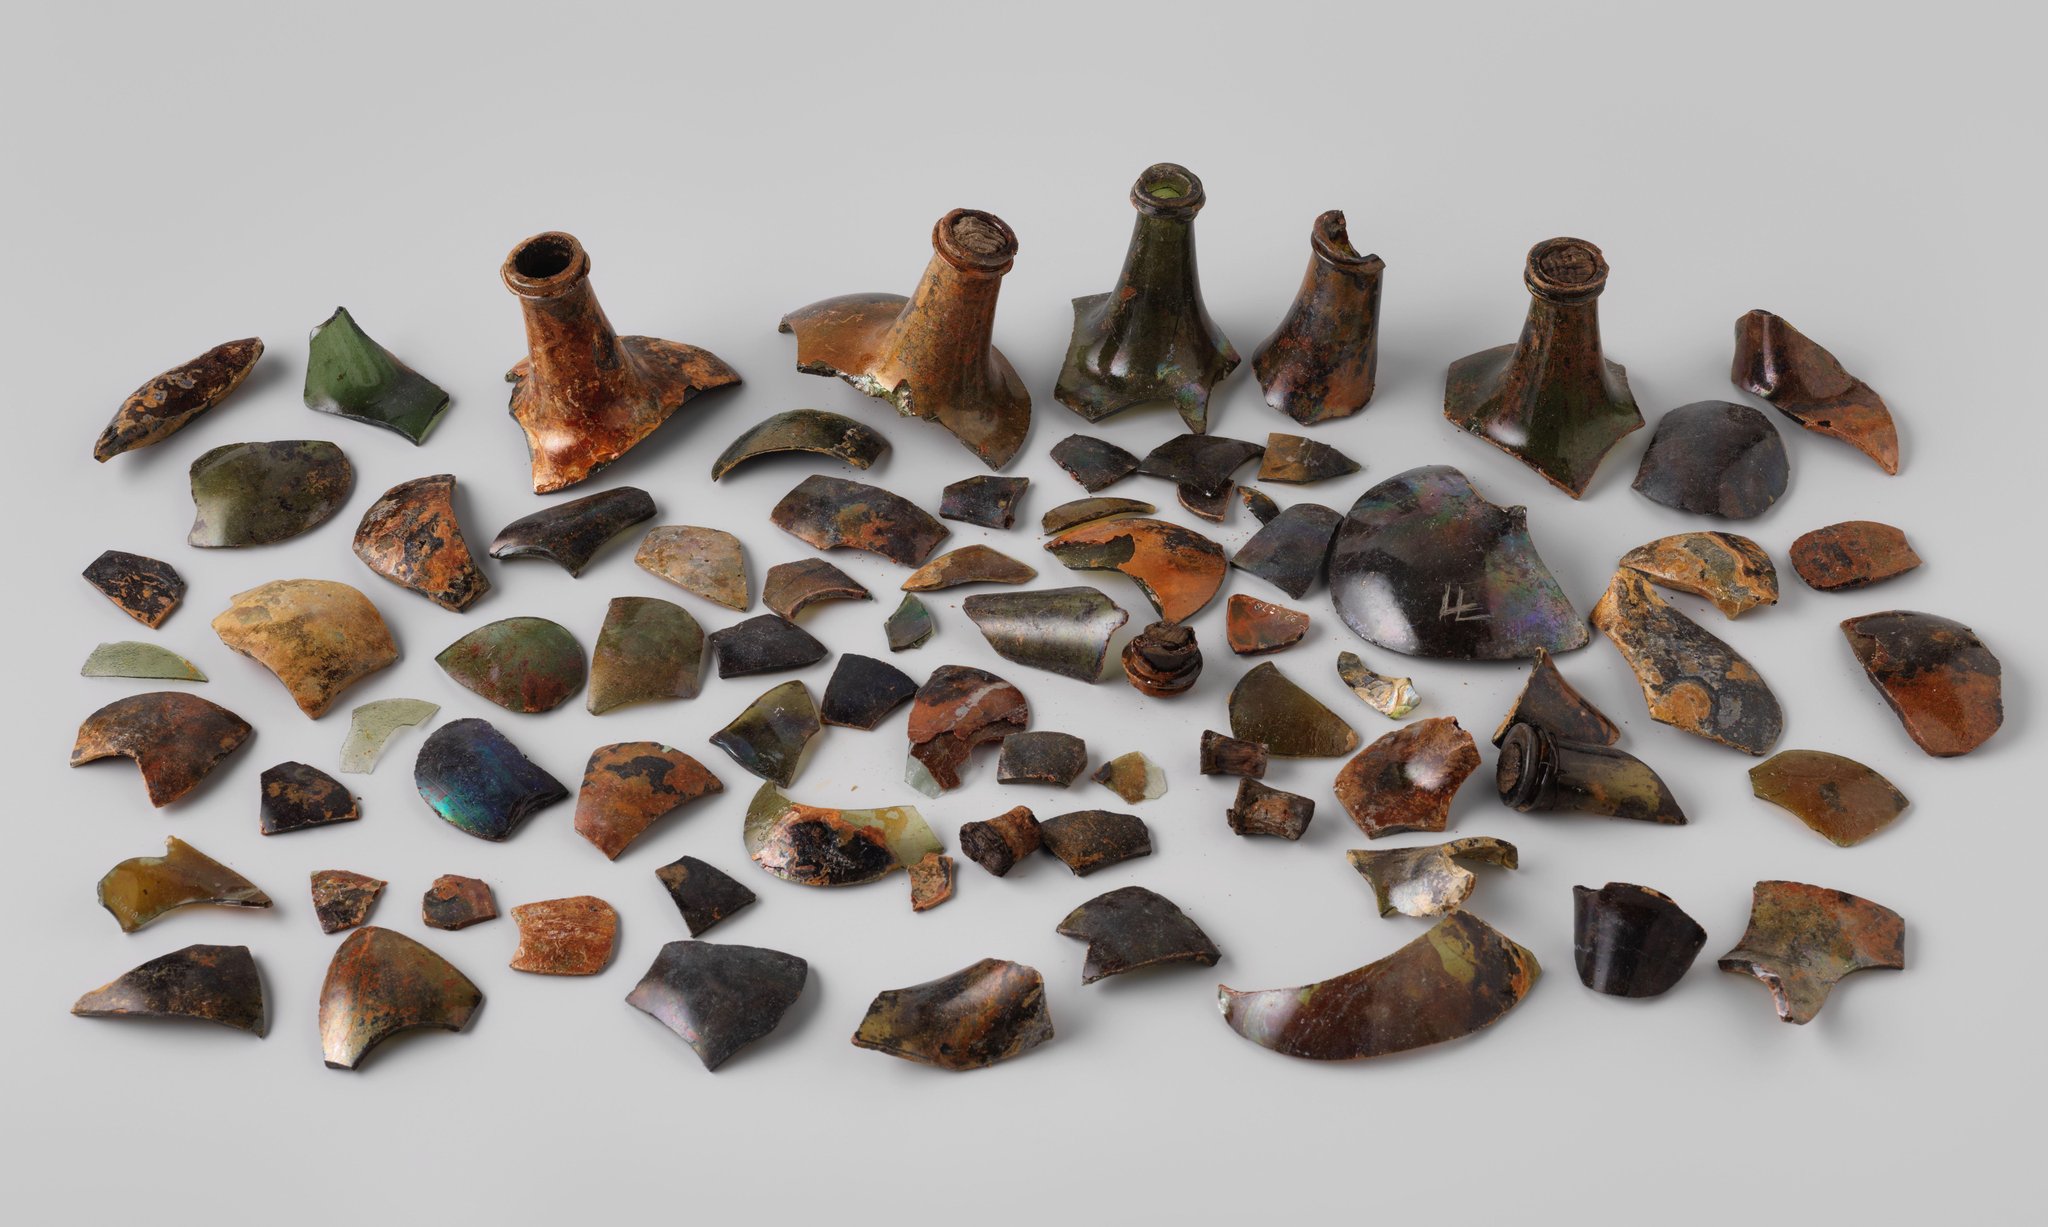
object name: wine bottle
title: Scherven van wijnflessen uit het wrak van de Oost-Indiëvaarder 't Vliegend Hart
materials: cork, glass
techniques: green glass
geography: netherlands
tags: 't vliegend hart (schip), verenigde oostindische compagnie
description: Scherven van uivormige wijnflessen van groen glas waar rode (port)wijn in heeft gezeten. Halzen met kurk.